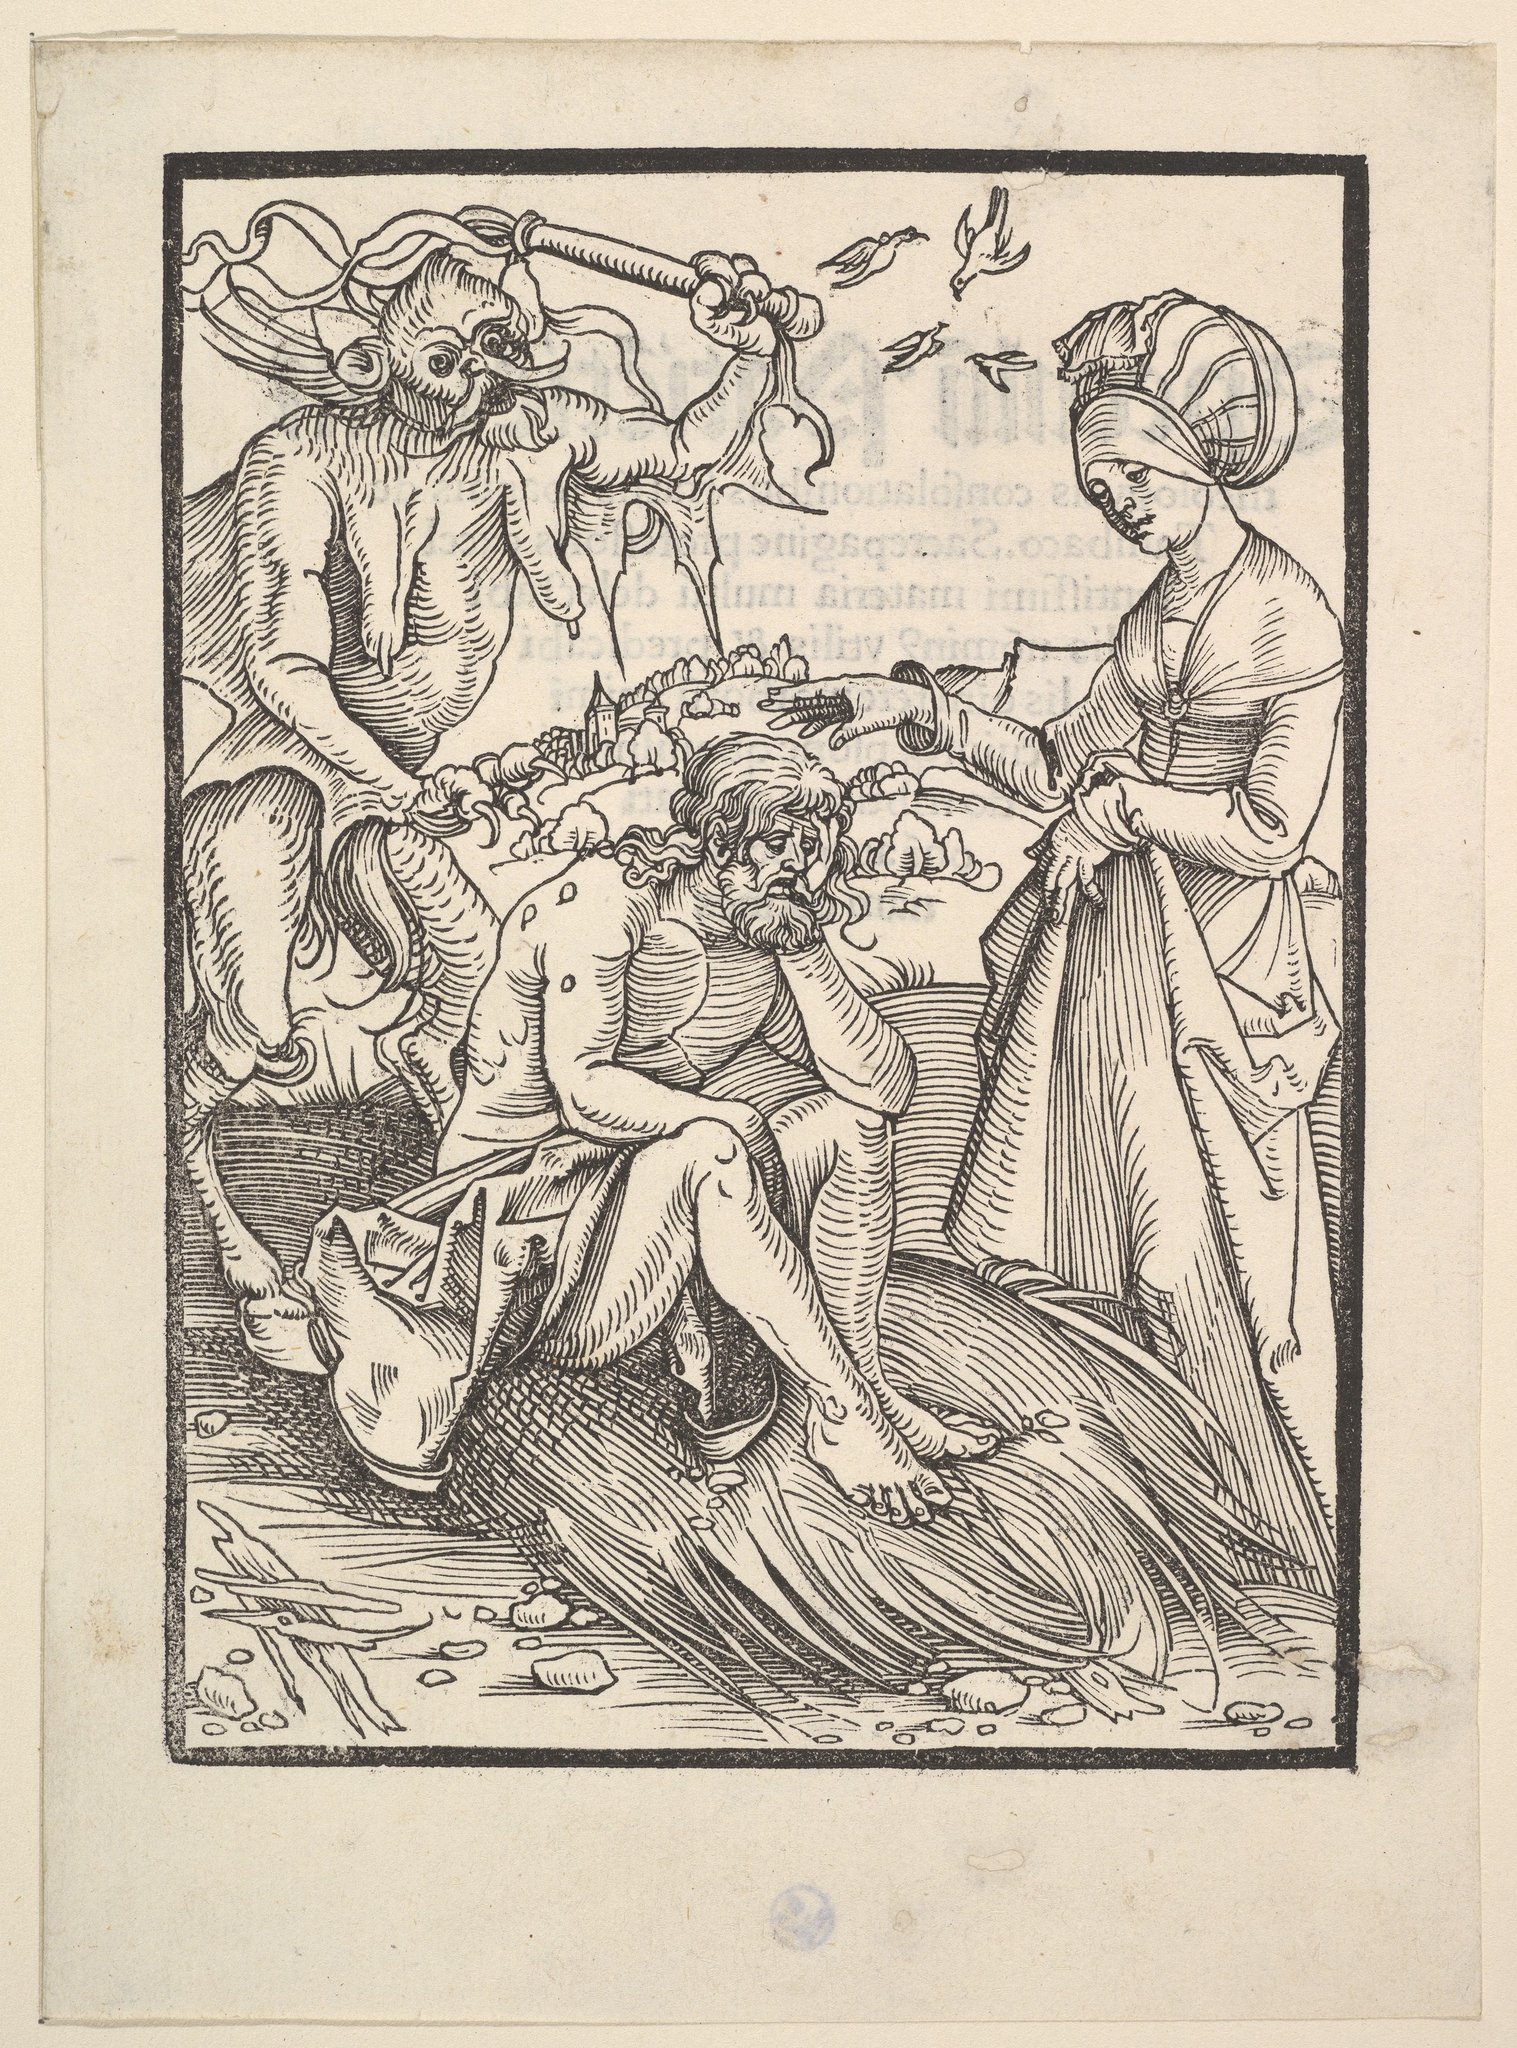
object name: print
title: Job Tempted by a Demon; verso text from the Speculum Patientiae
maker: hans baldung (called hans baldung grien)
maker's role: artist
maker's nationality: german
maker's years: 1484-1545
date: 1509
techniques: woodcut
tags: women,demons,job